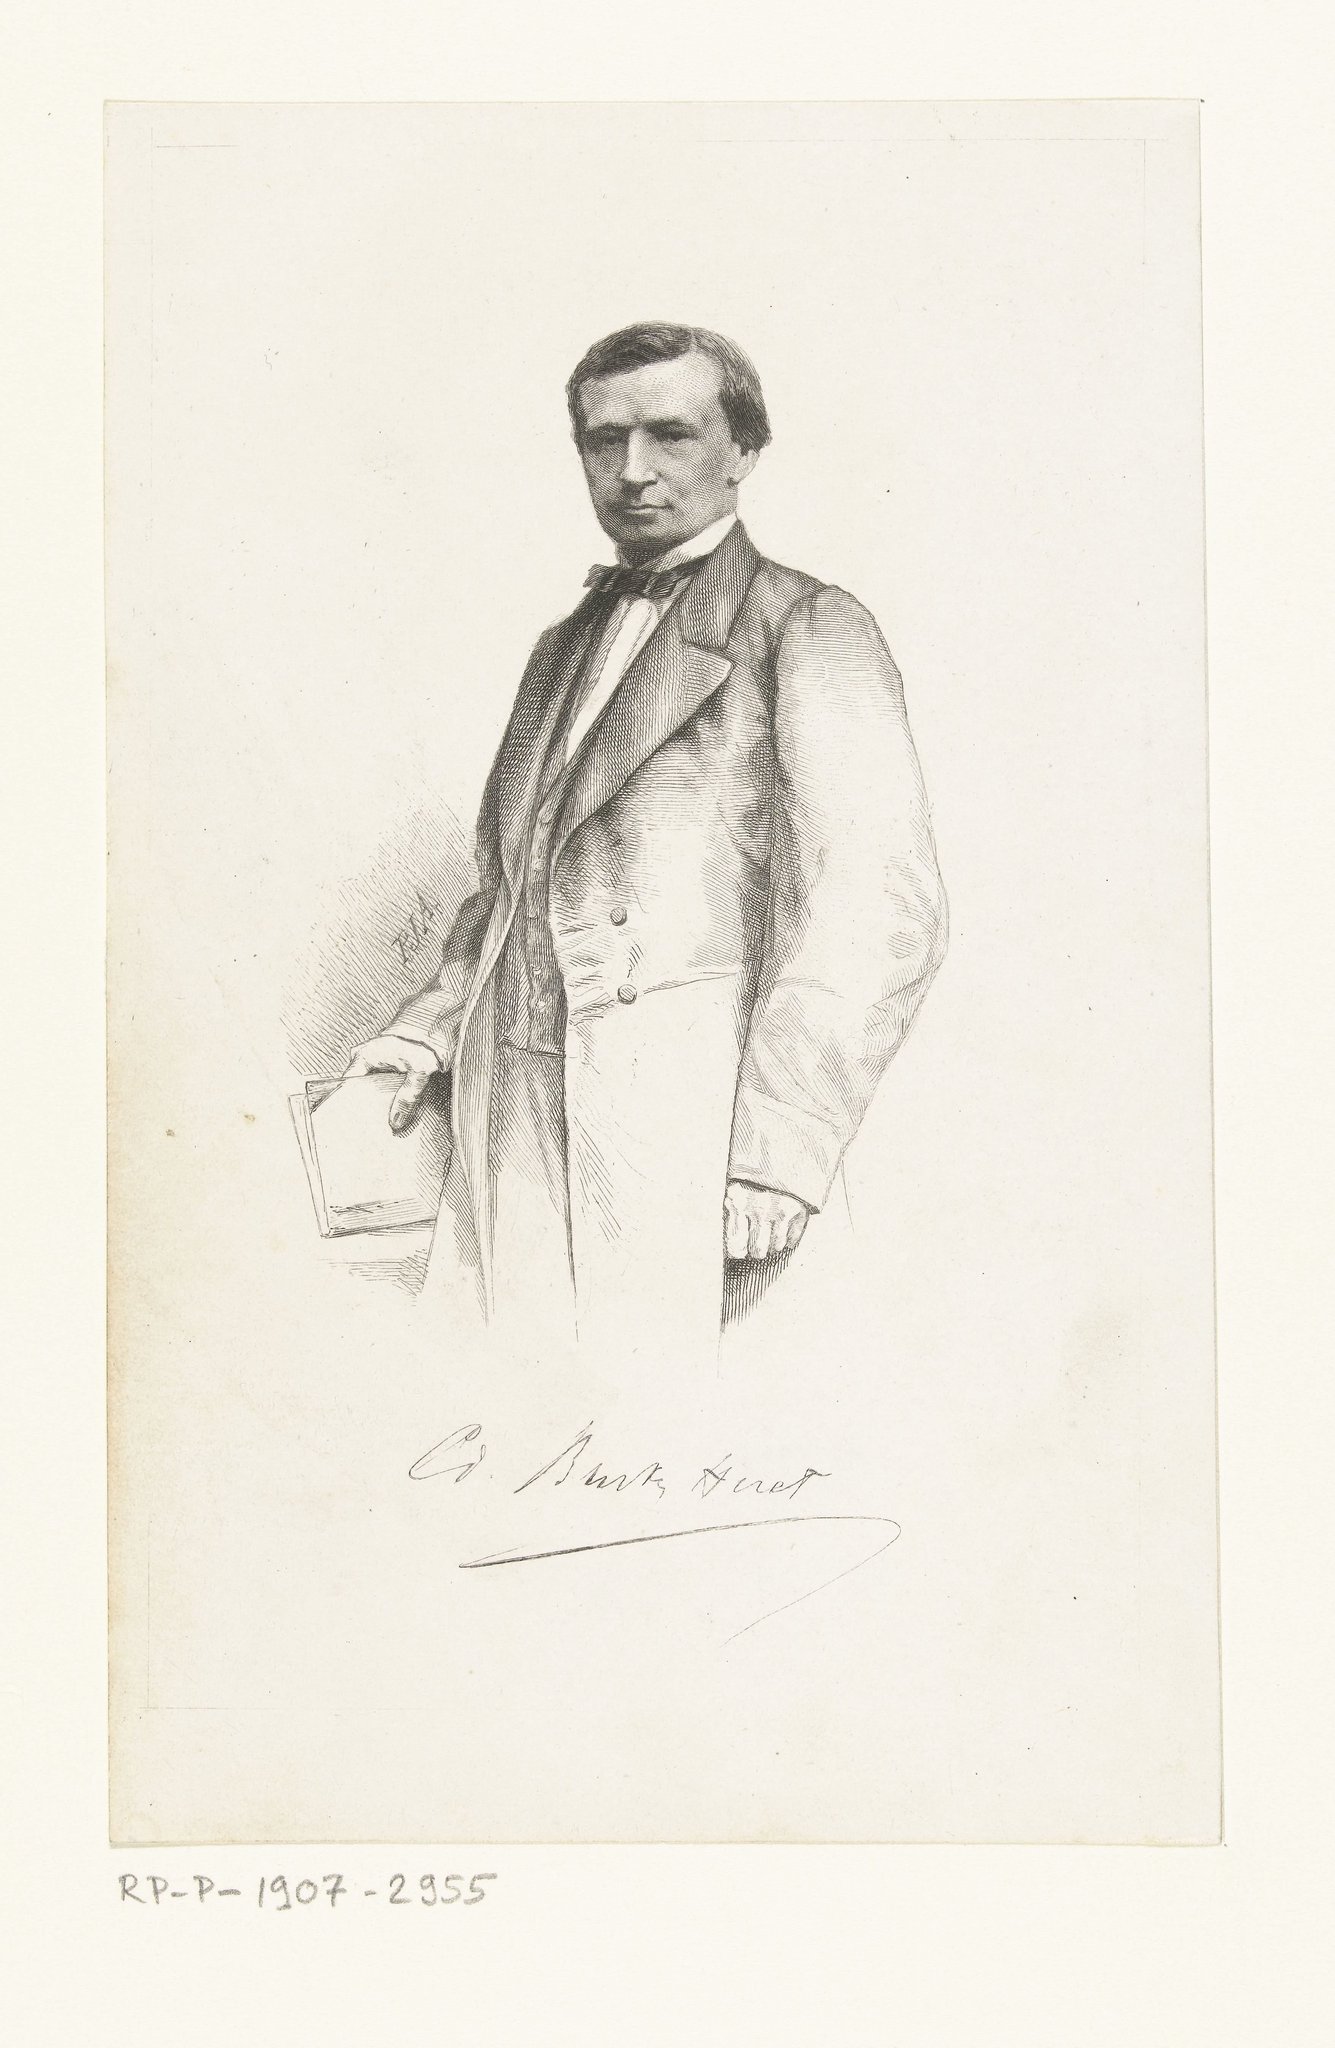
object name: print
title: Portret van Conrad Busken Huet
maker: petrus johannes arendzen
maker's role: draughtsman, print maker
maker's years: 1846-1932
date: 1856-1886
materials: paper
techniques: engraving, etching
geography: netherlands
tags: the hague, paris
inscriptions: collector's mark: Lugt 2228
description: Portret van Conrad Busken Huet ten halver lijve, met boek in zijn hand. Onder het portret zijn handtekening in facsimile.